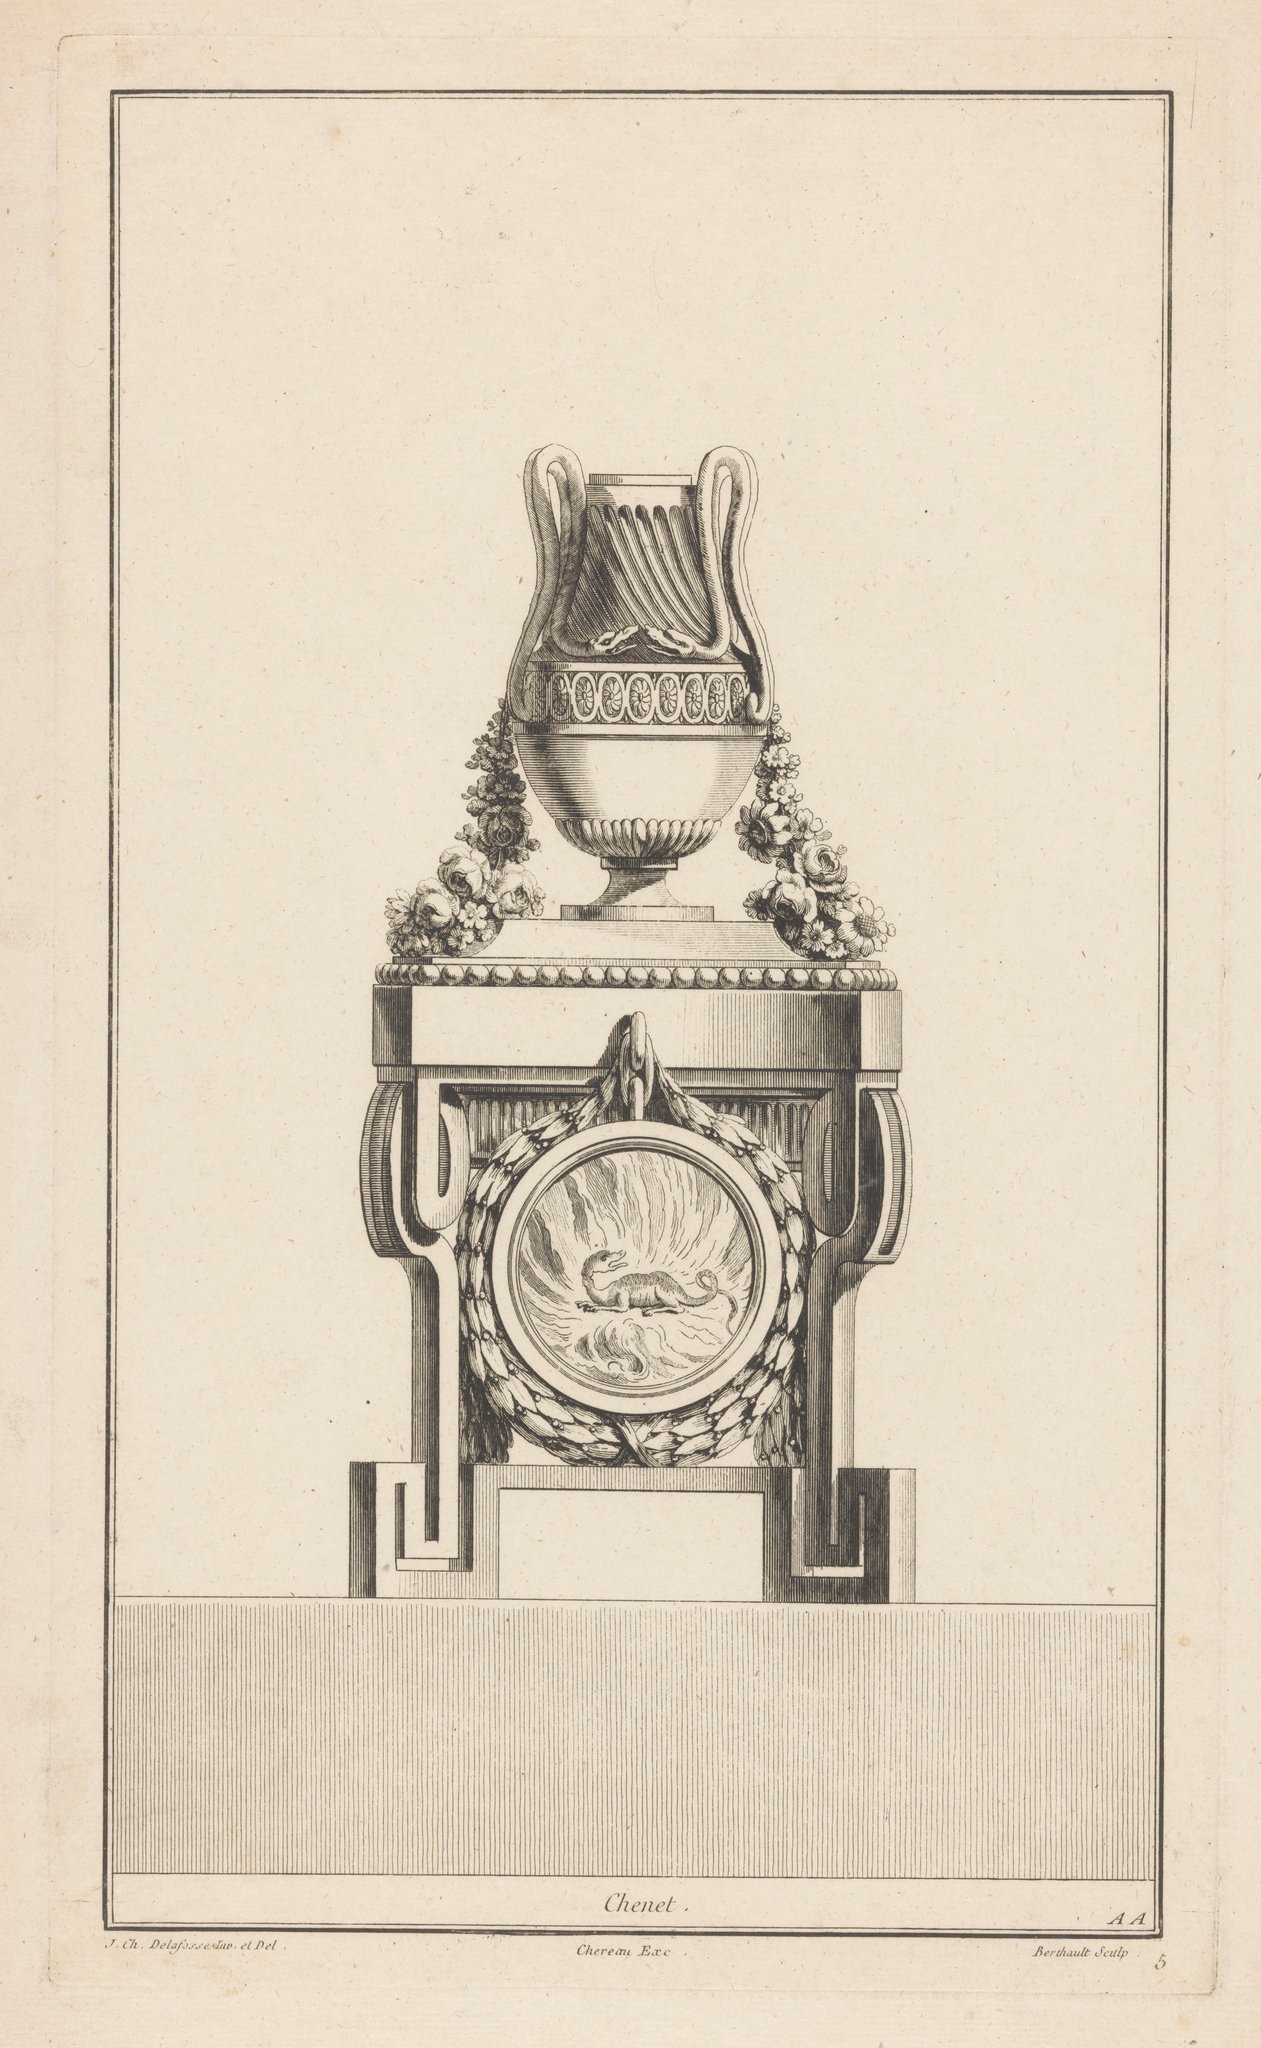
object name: ornament print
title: Vuurbok met vaas en medaillon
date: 1771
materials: paper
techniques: engraving, etching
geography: paris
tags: andiron, fire-dog, ornament ~ medallion, vase ~ ornament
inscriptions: collector's mark: Lugt 2228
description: Een geornamenteerde vuurbok met een vaas met slangen en bloemen en een rond medaillon met een draak.